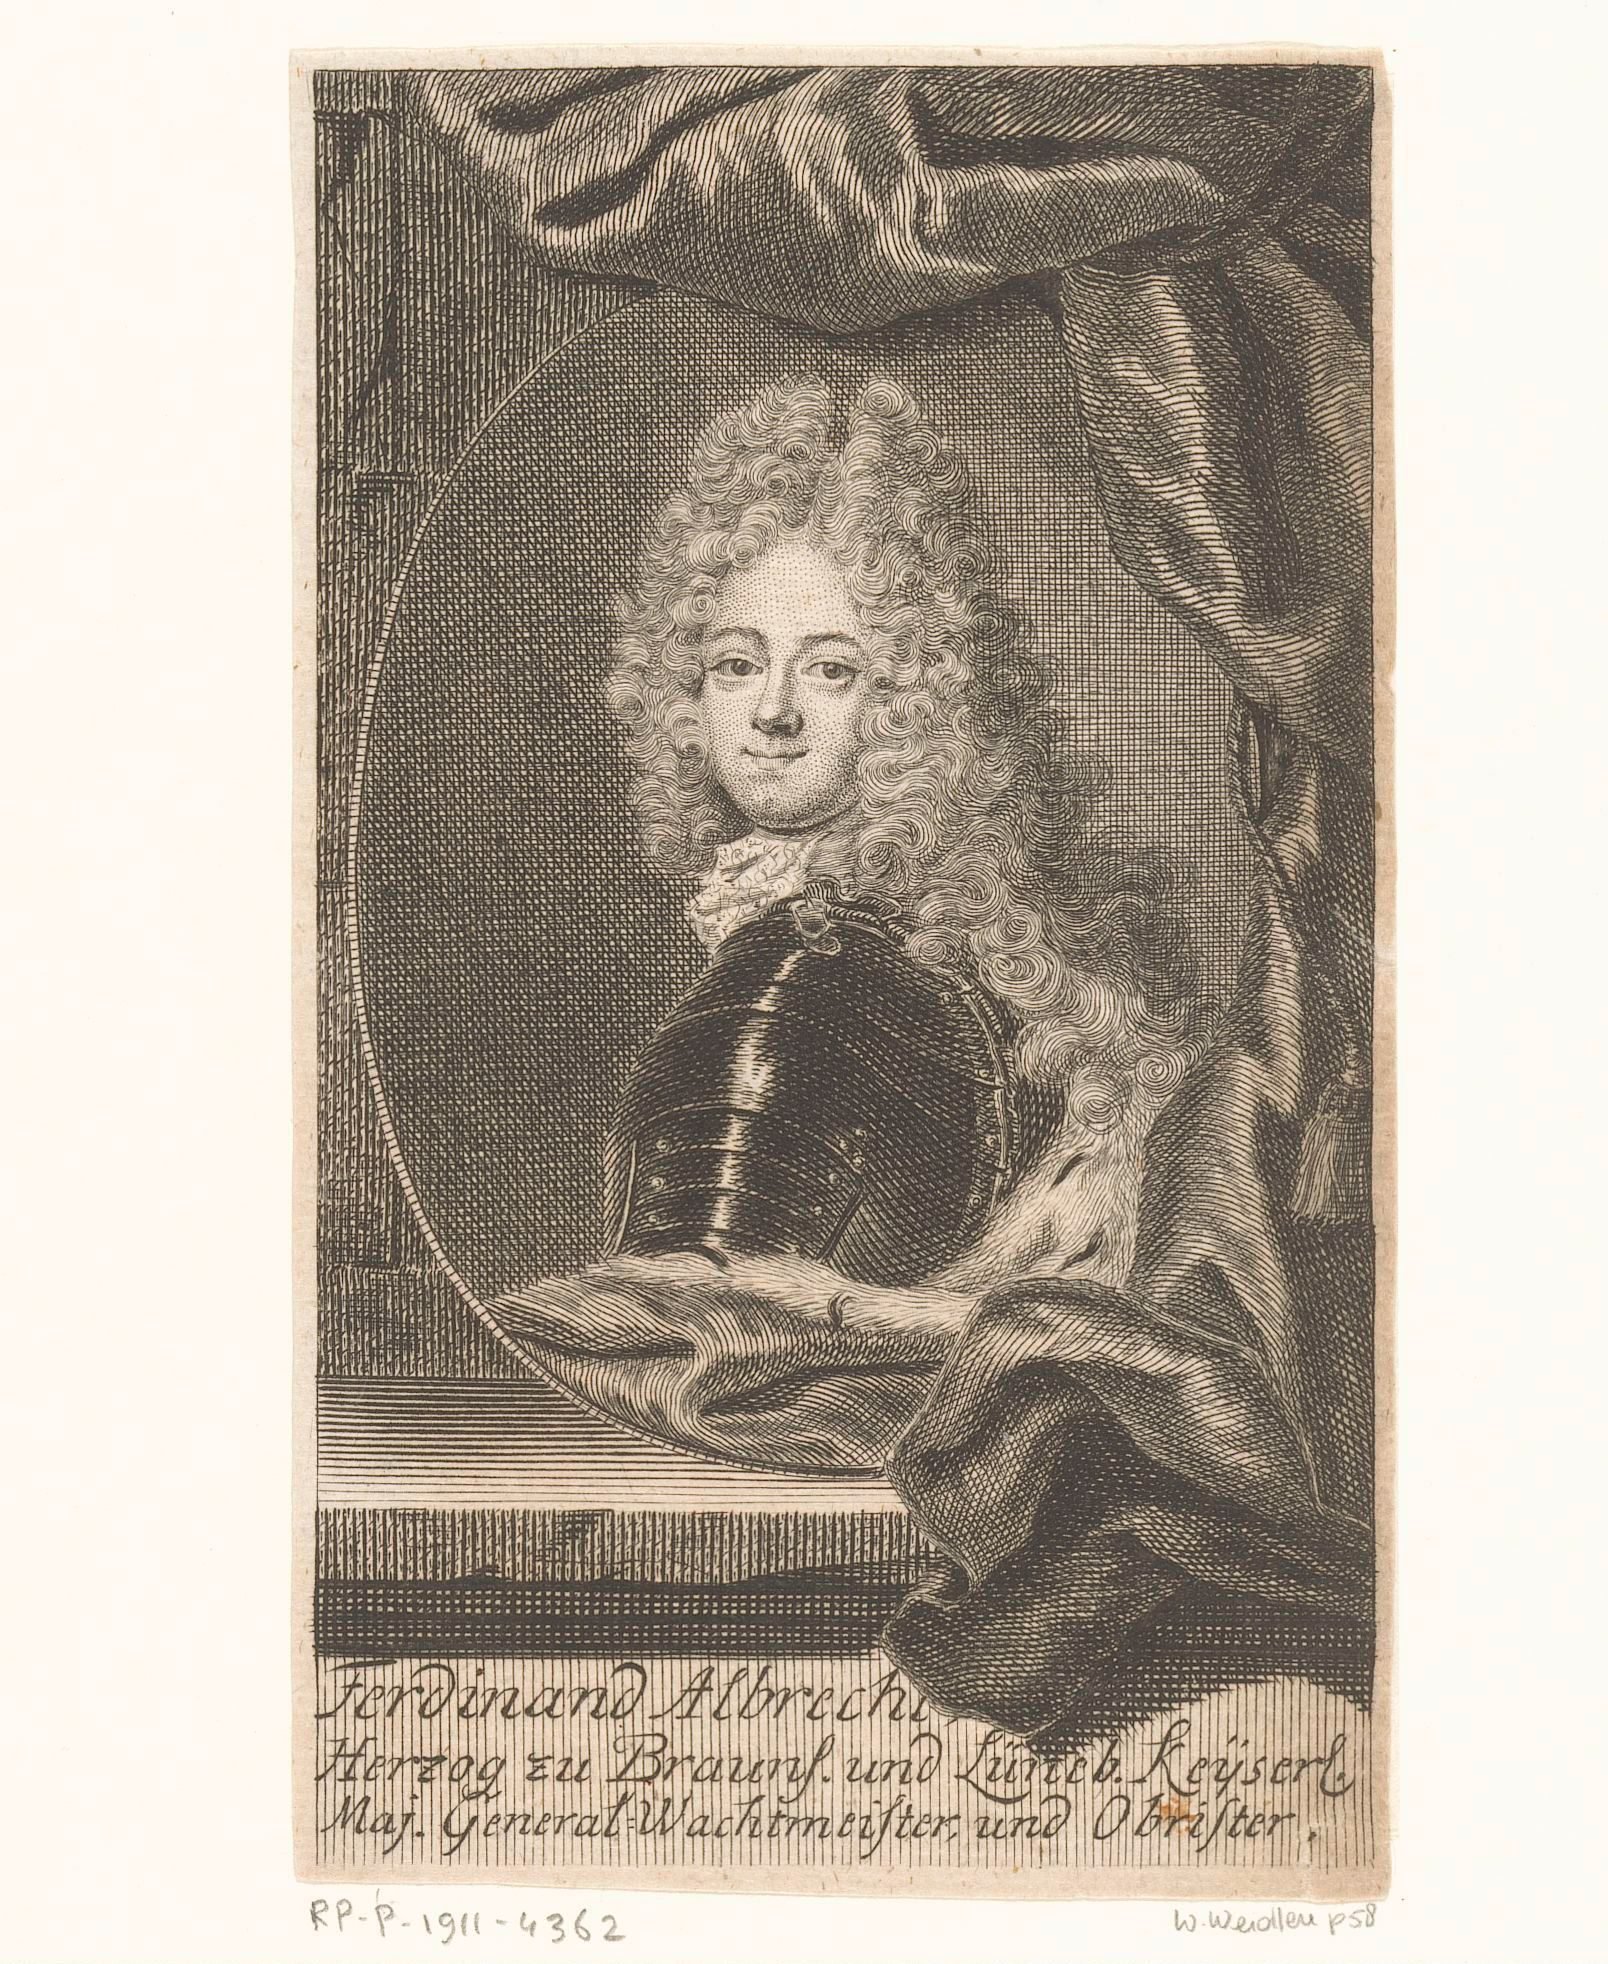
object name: print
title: Portret van Ferdinand Albrecht II von Braunschweig-Wolfenbüttel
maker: martin bernigeroth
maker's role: print maker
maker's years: 1670-1733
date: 1711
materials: paper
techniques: engraving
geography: leipzig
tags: armour, historical persons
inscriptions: collector's mark: Lugt 2228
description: Prent ook gebruikt in: Die Europäische Fama, Welche den gegenwärtigen Zustand der vornehmsten Höfe entdecket. dl. 109. Leipzig: Gleditsch, 1711